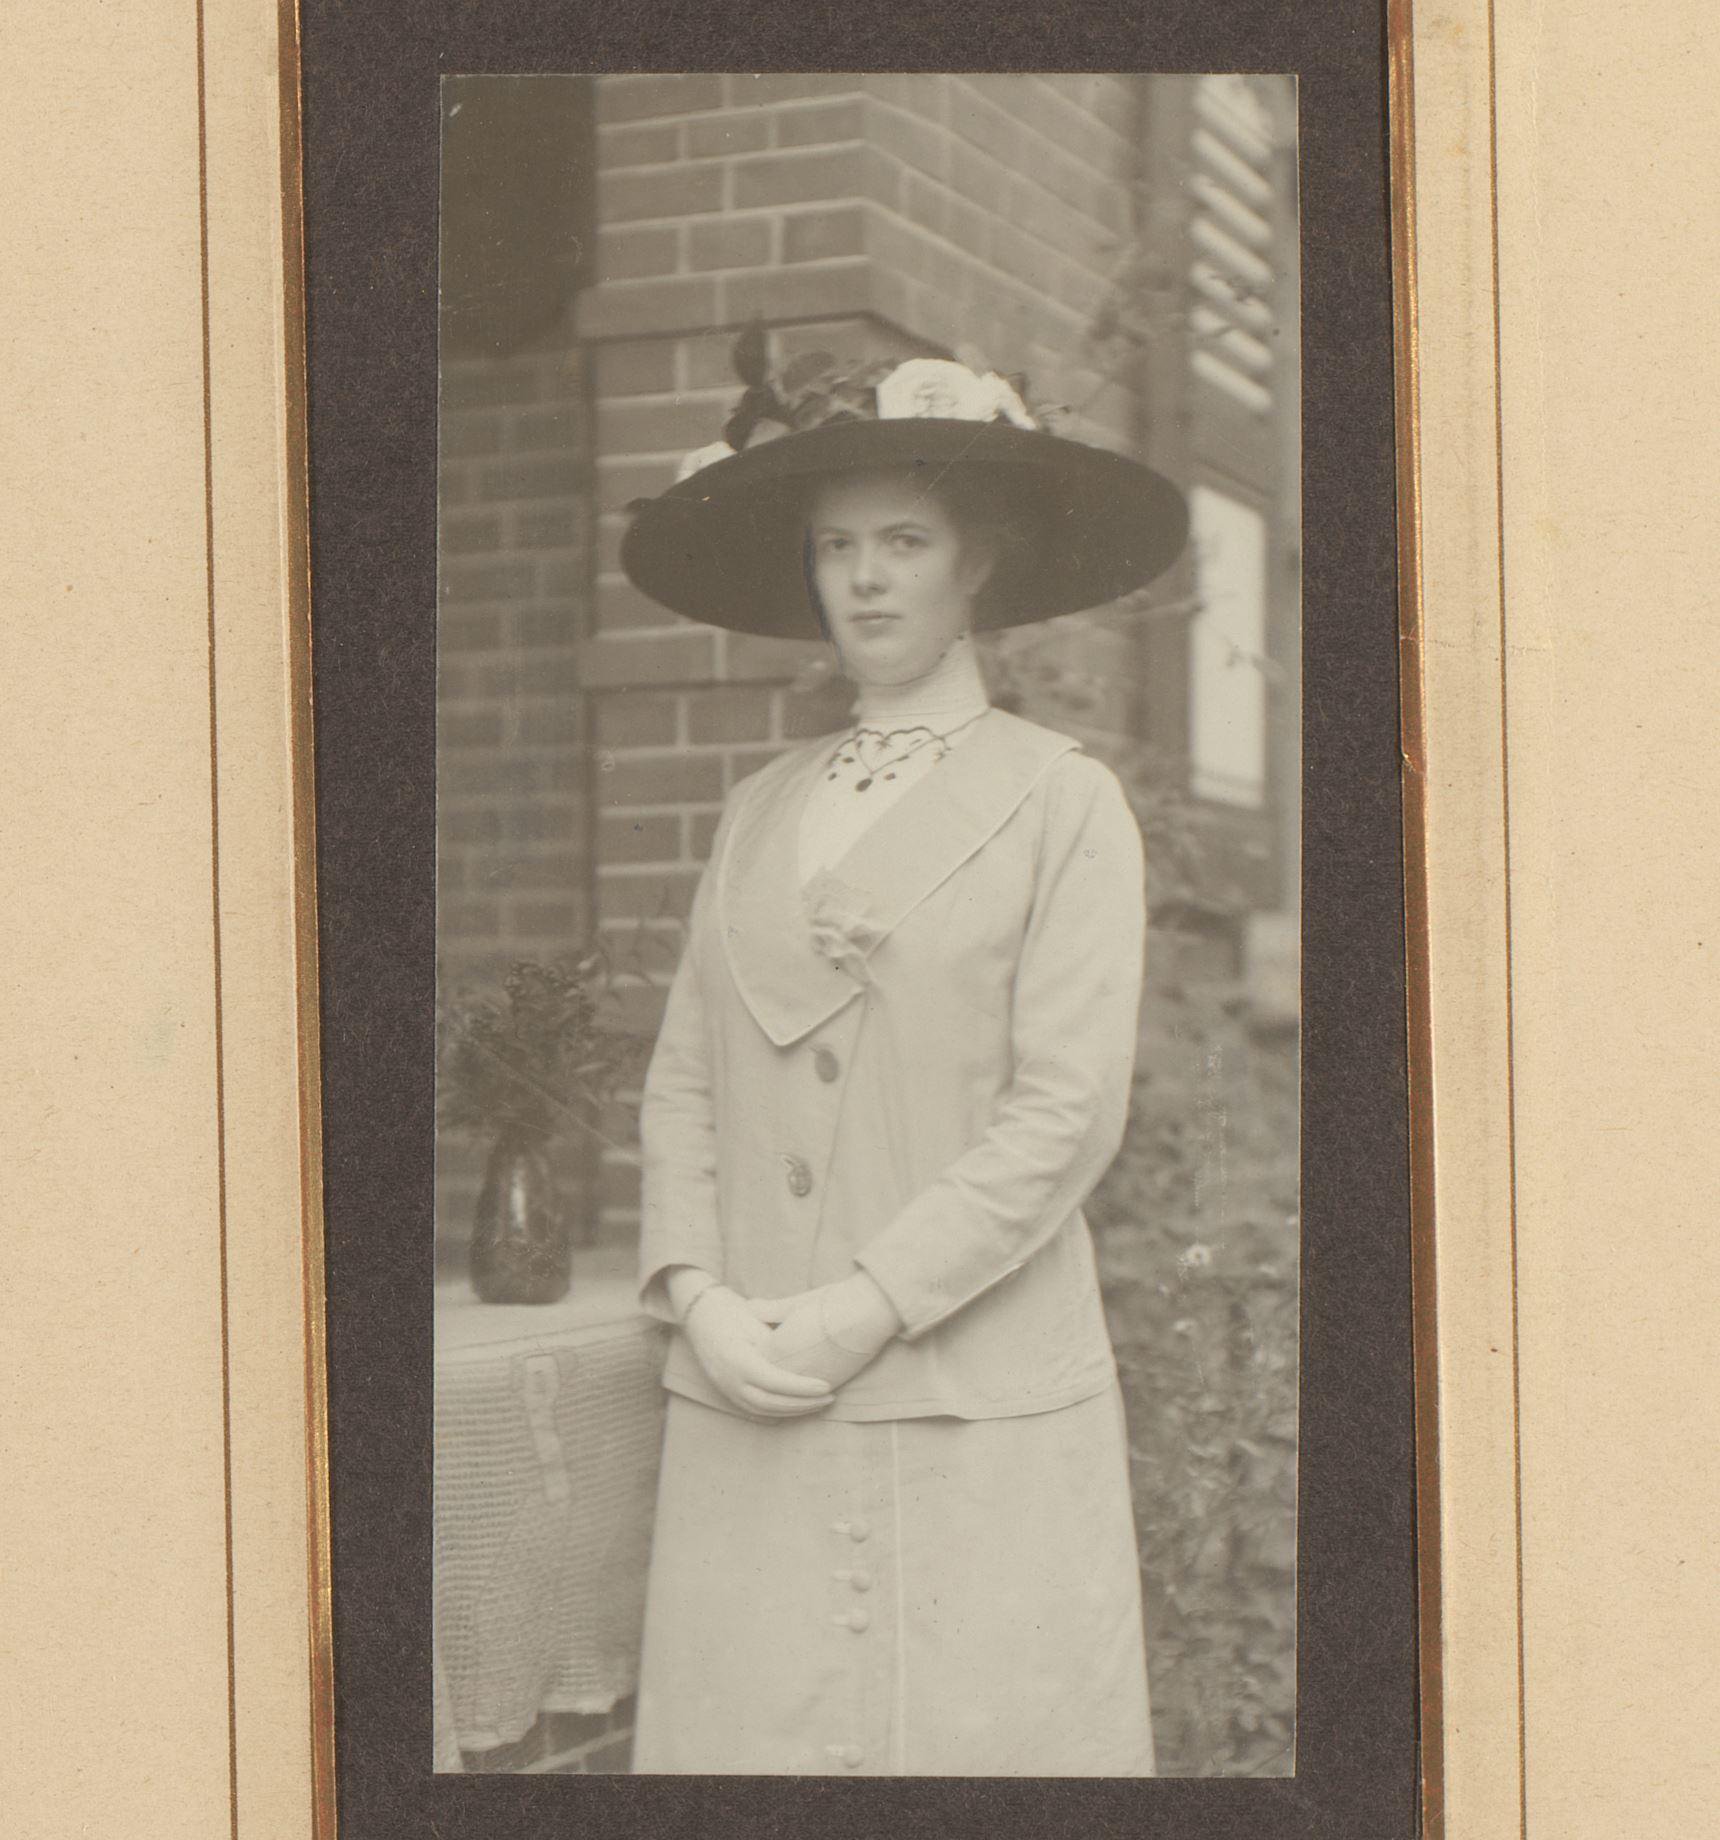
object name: photograph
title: Portret van vrouw met hoed en witte handschoenen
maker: Anonymous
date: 1890-1920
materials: cardboard, photographic support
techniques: collodion silver print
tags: historical persons - bb - woman, head-gear: hat